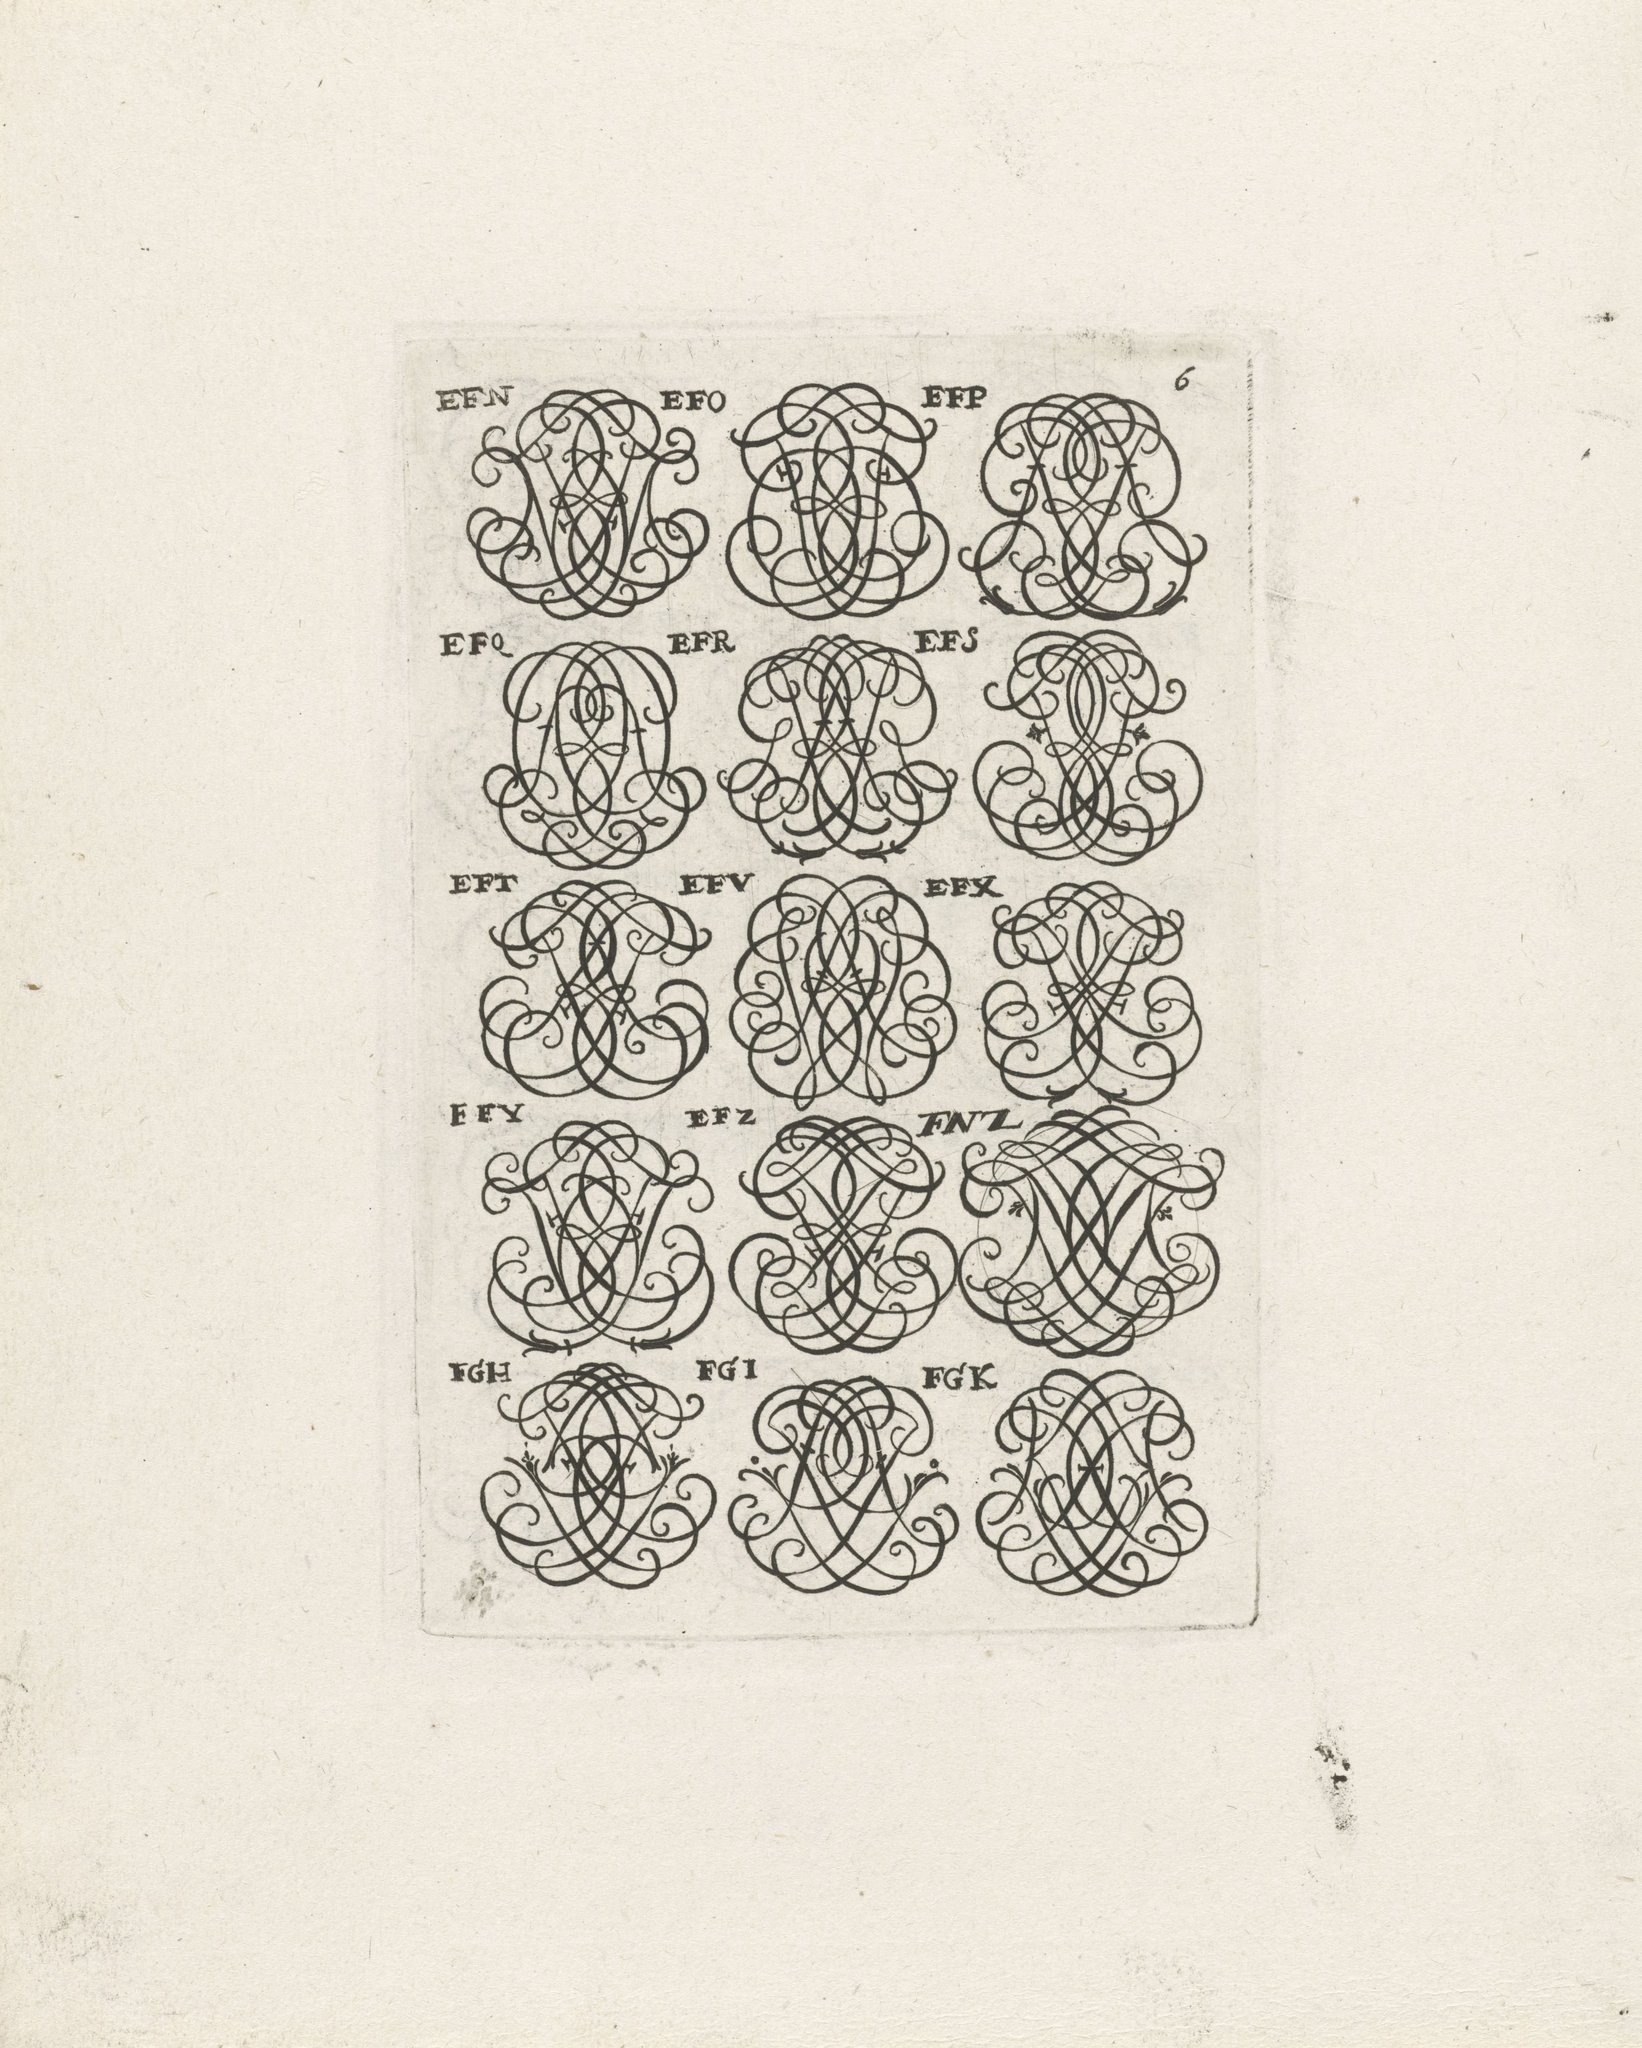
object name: ornament print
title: Livre nouveau et utile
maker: daniel de lafeuille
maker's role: print maker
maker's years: 1640-1709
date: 1690-1691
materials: paper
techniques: engraving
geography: amsterdam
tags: letters, alphabet, script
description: Uit serie van 29 deels genummerde bladen met cijfermonogrammen.